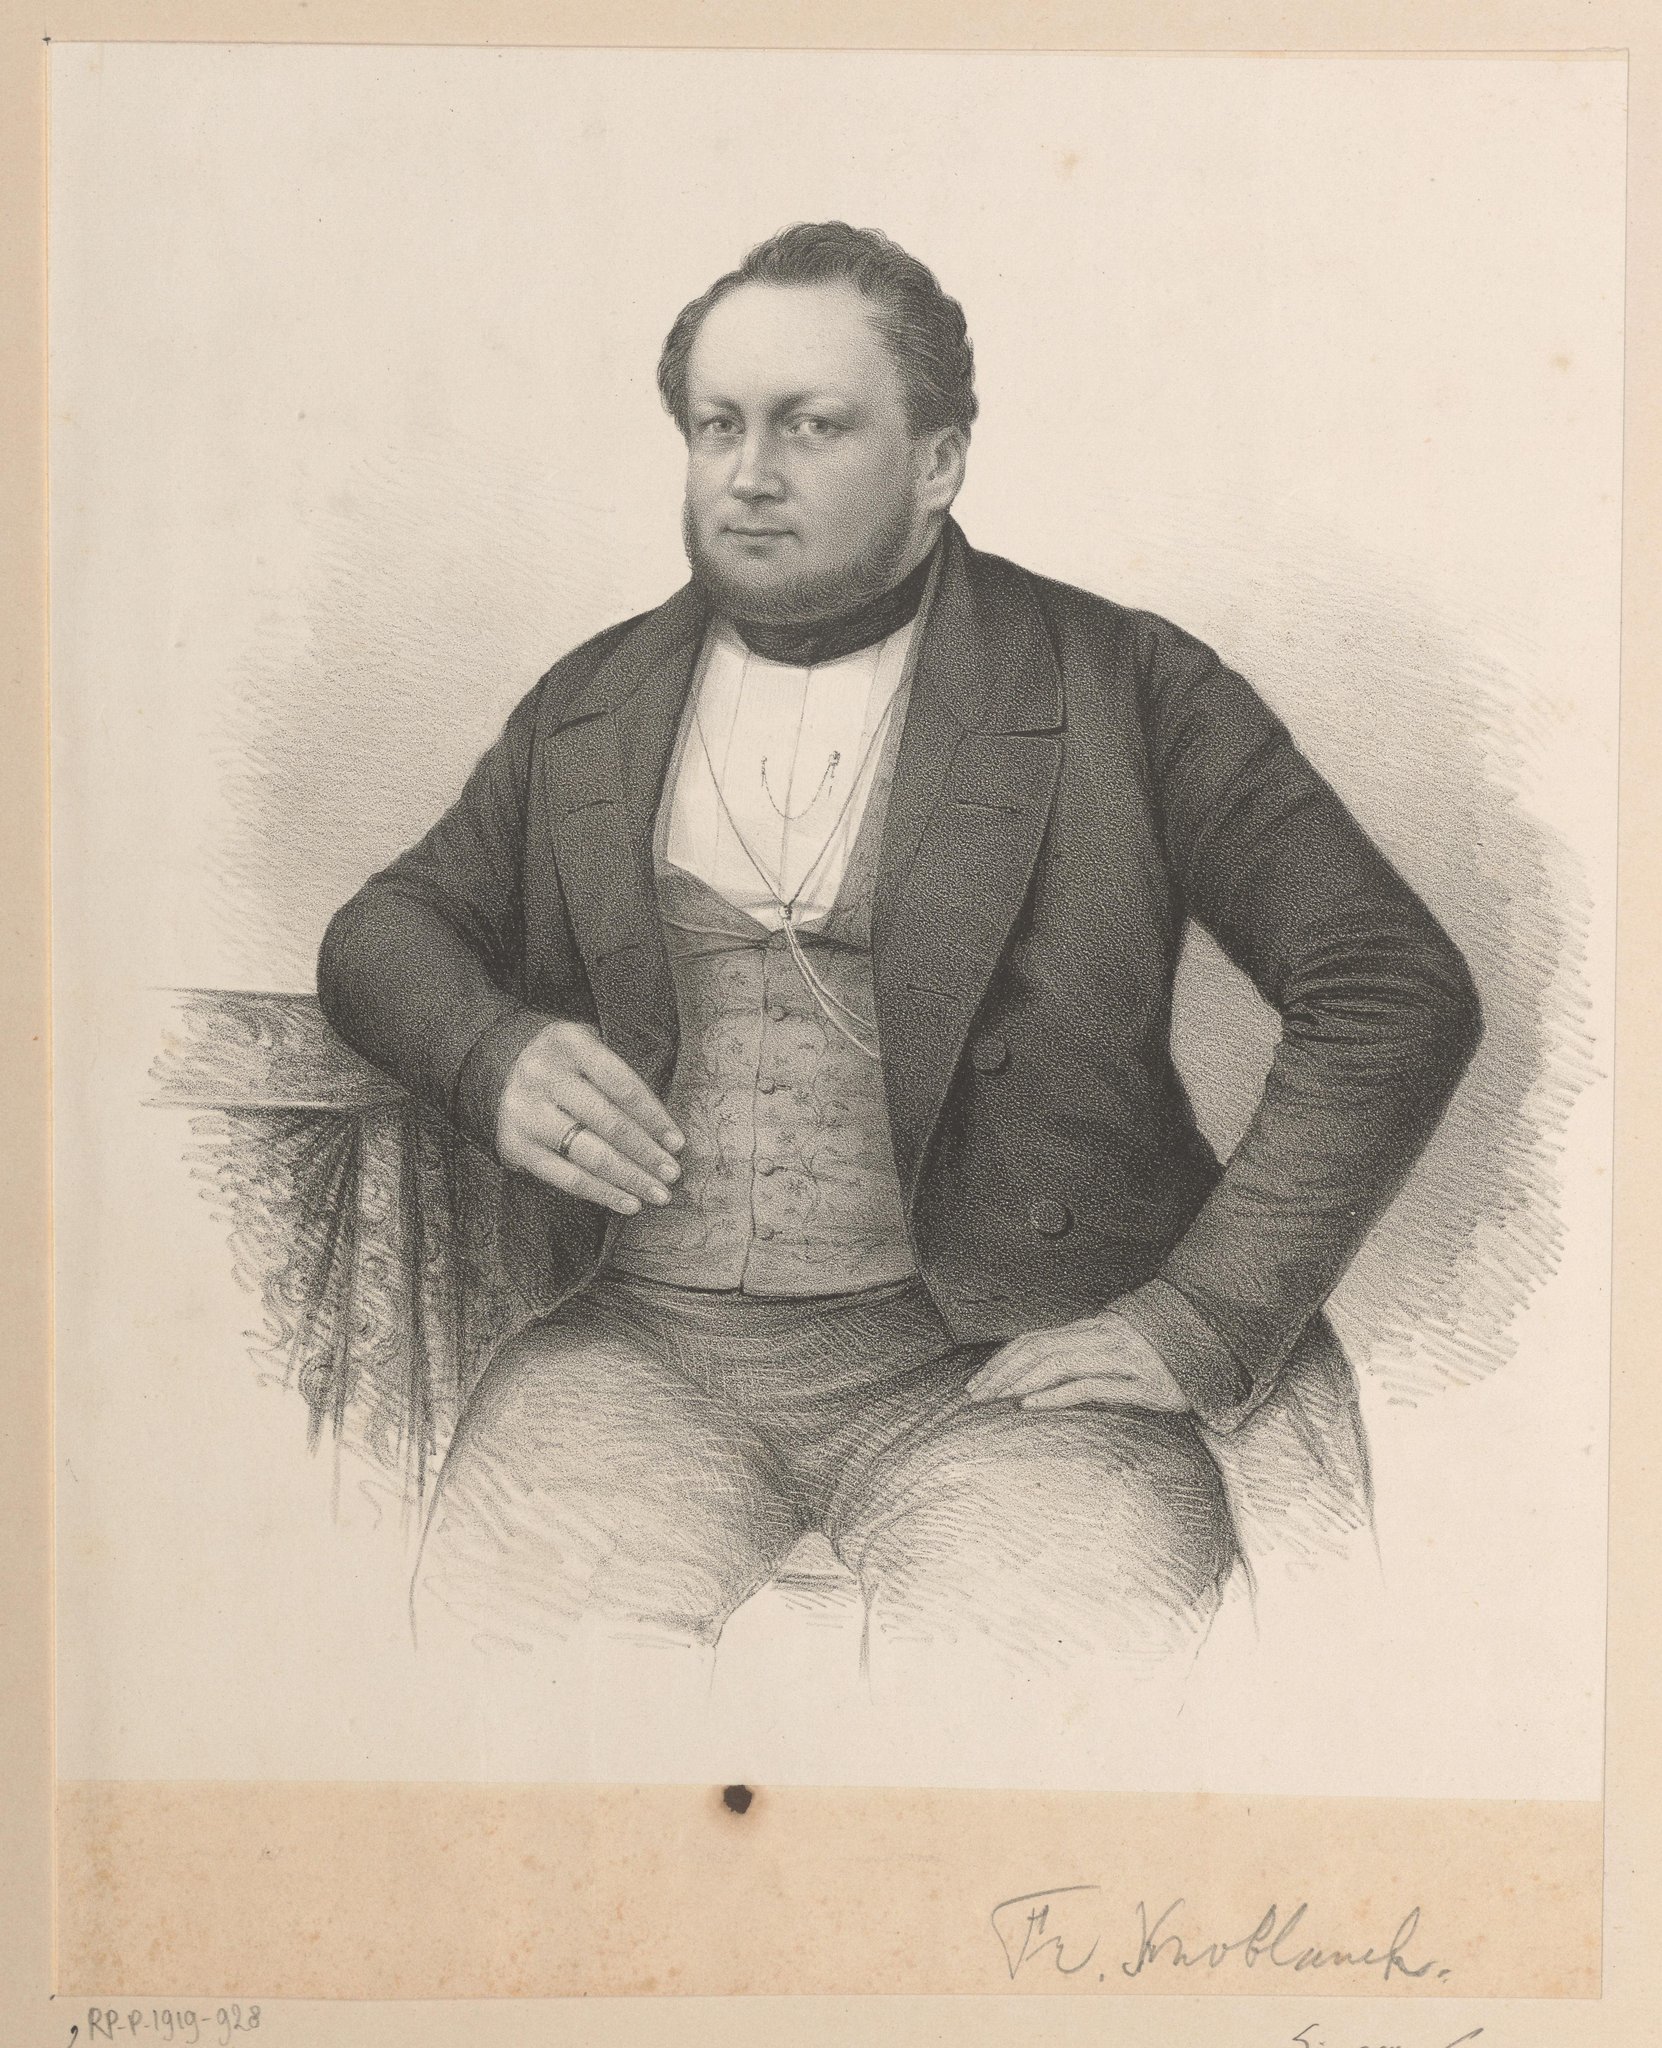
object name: print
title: Portret van Friedrich Knoblauch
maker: Anonymous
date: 1888-1919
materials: paper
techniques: lithograph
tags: historical persons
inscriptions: collector's mark: Lugt 2228